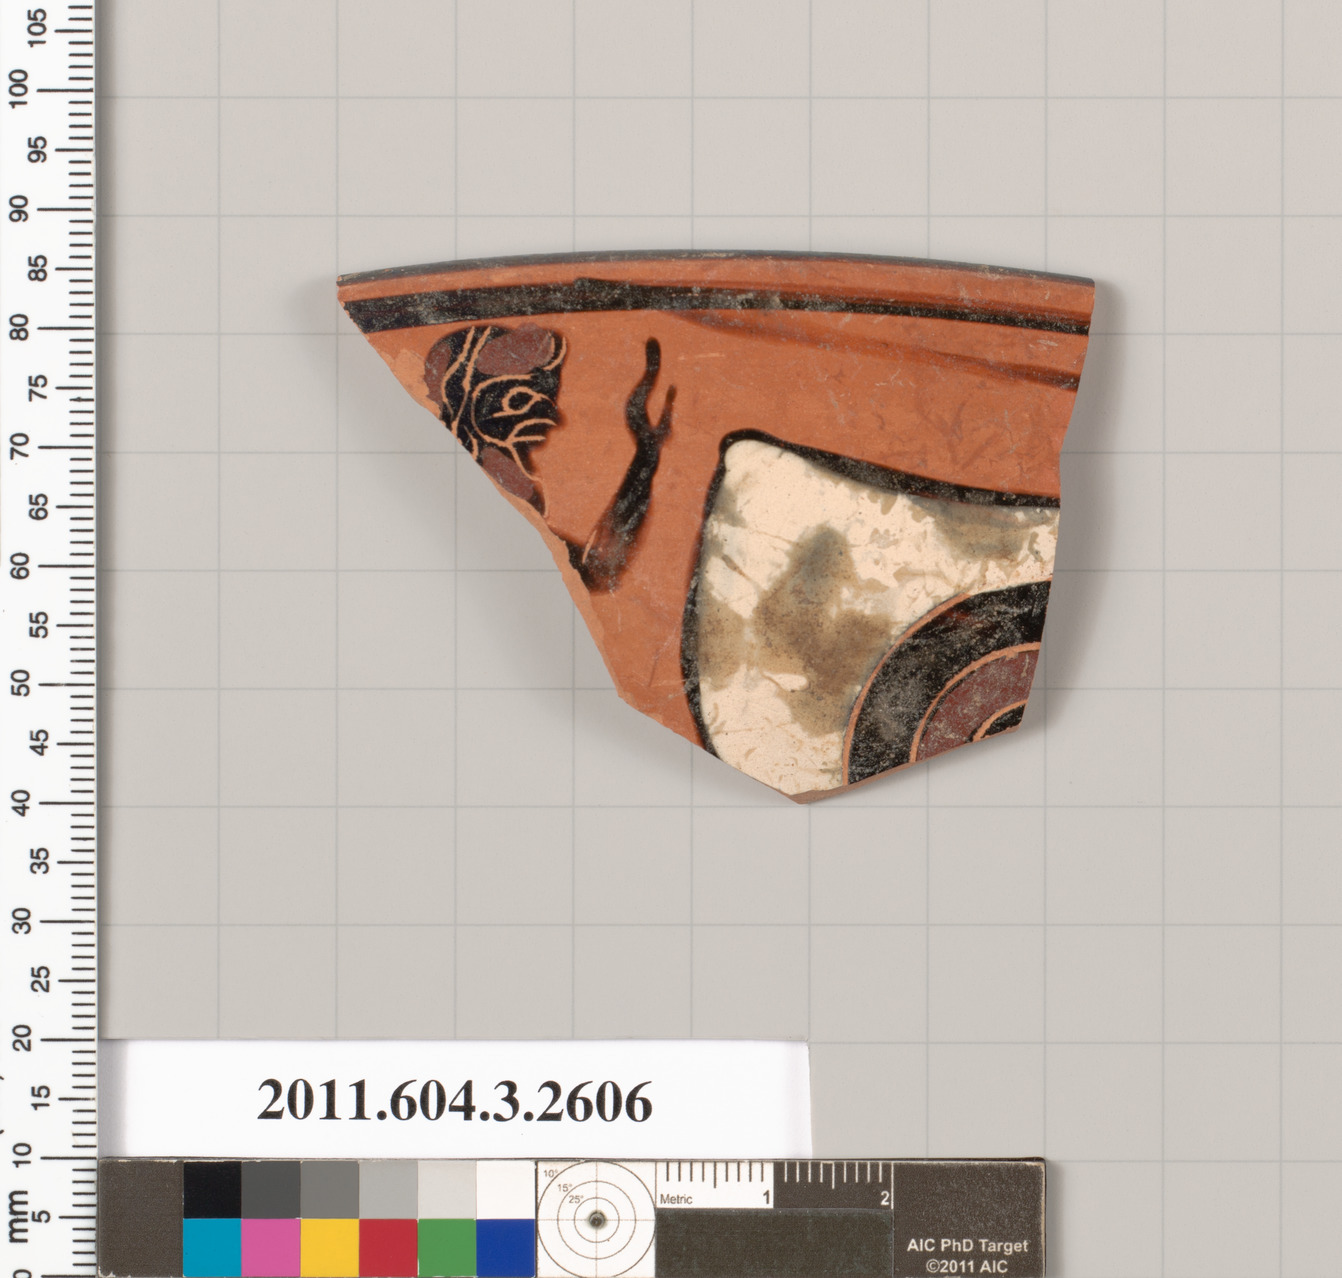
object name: kylix fragment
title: Terracotta rim fragment of a kylix: eye-cup (drinking cup)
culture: greek, attic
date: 525-501 BCE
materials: terracotta